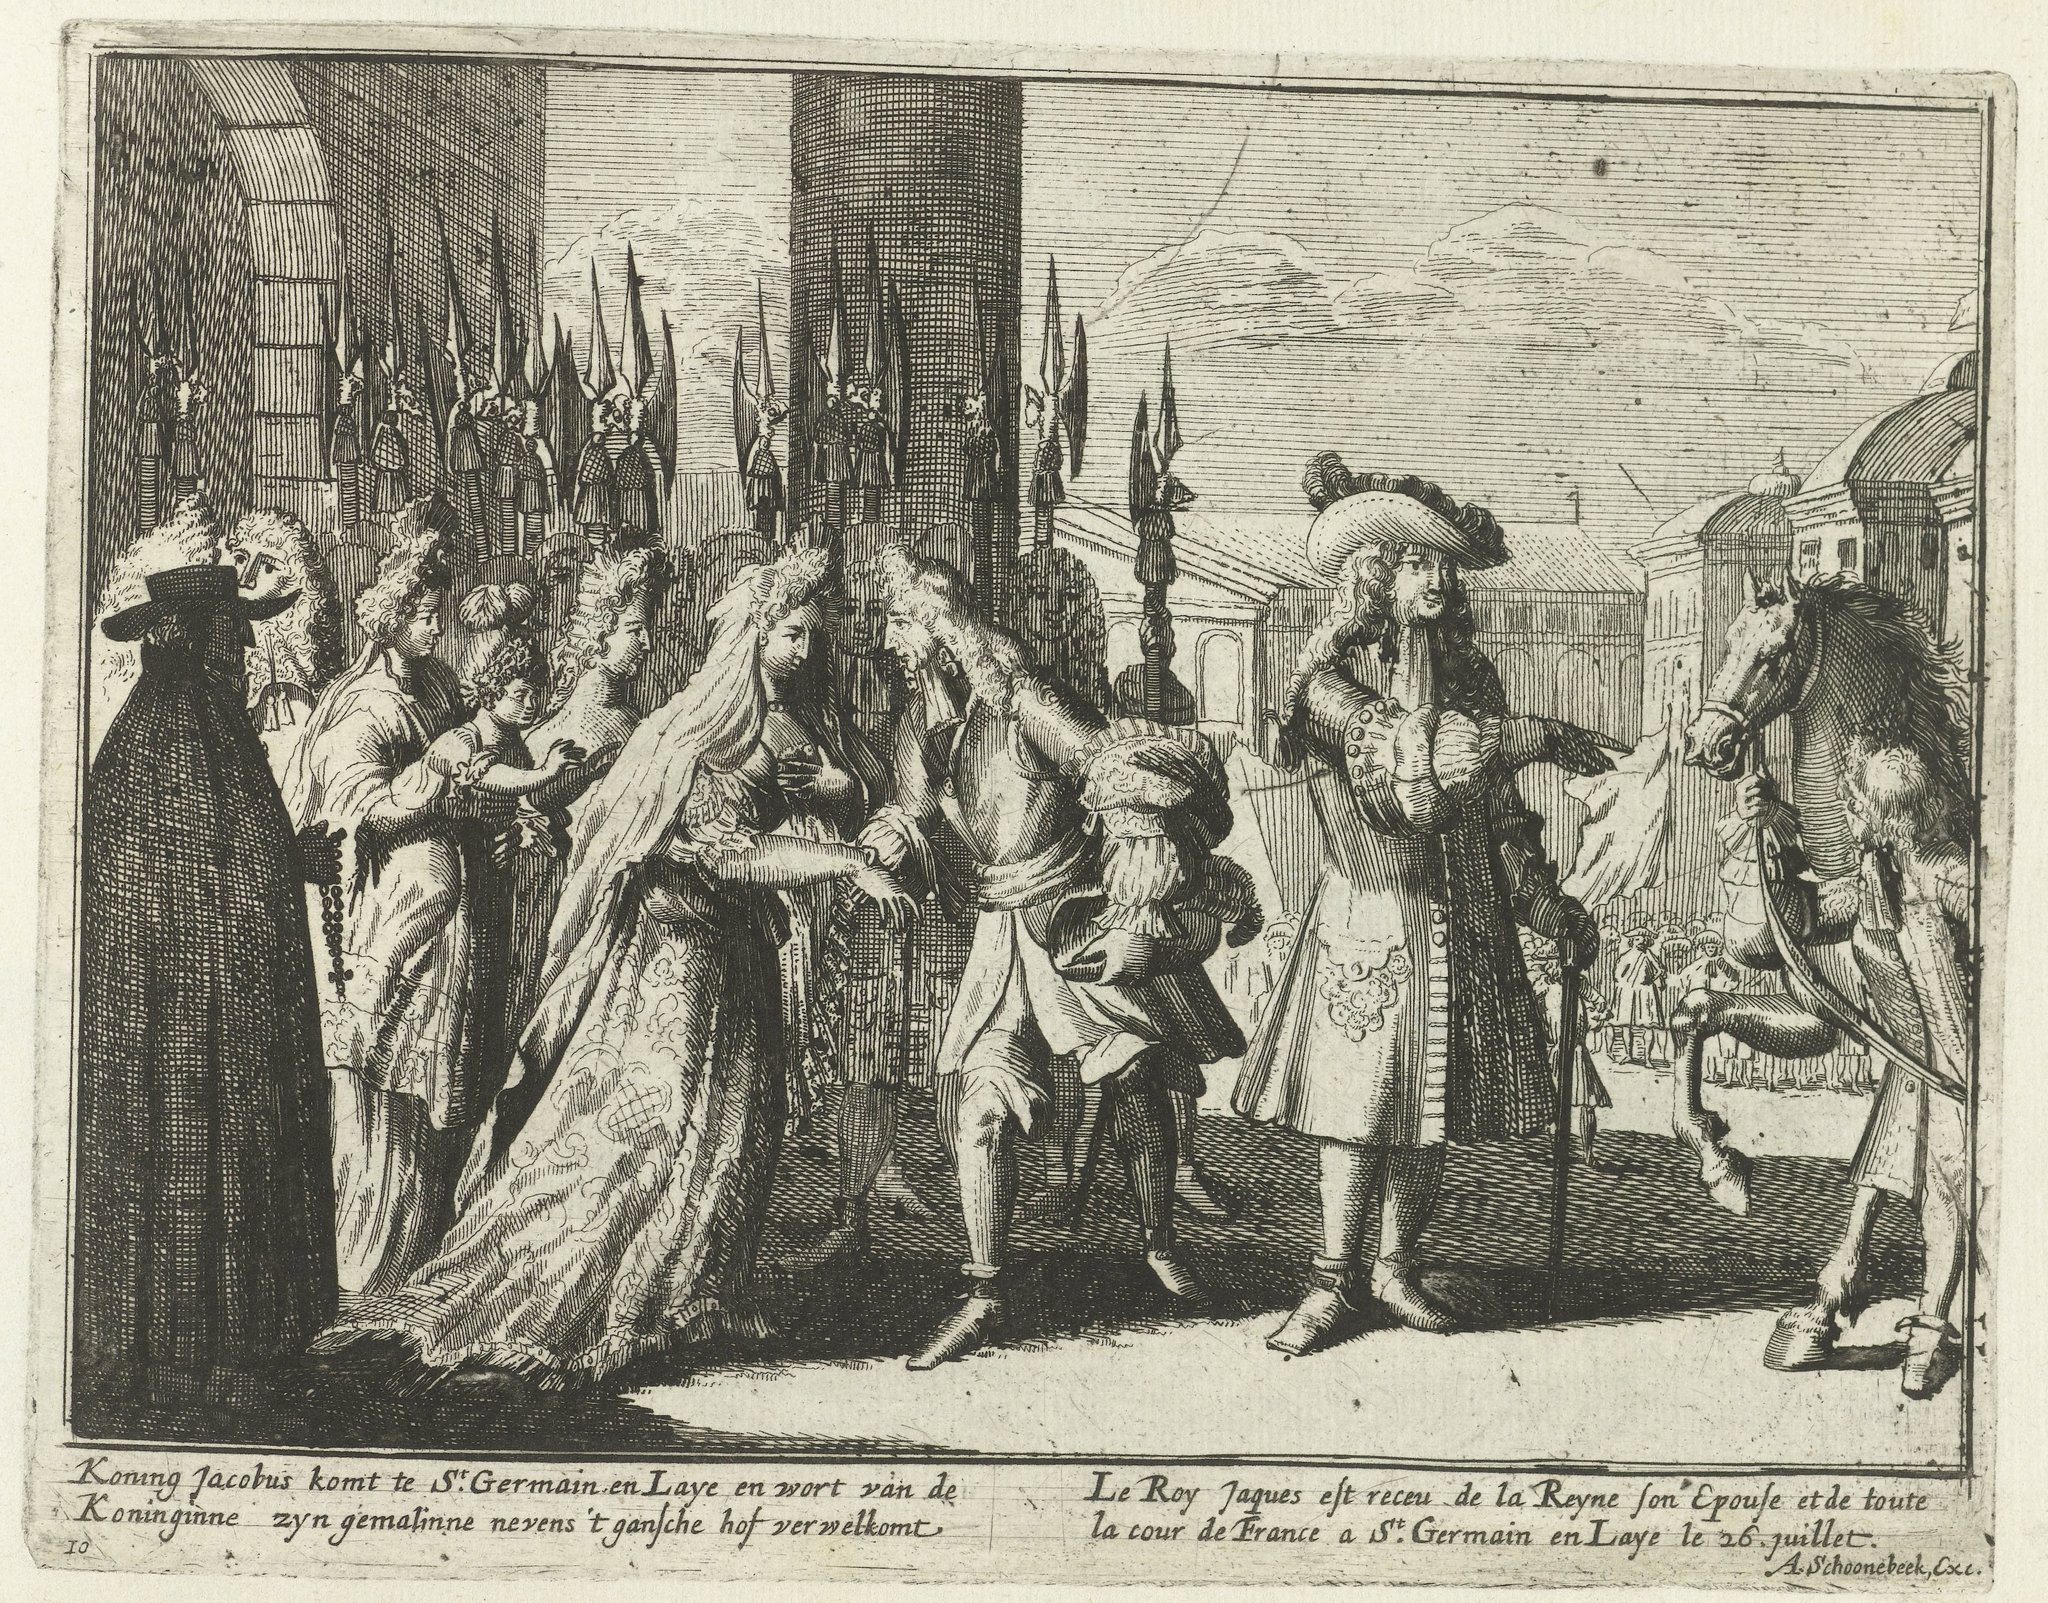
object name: print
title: Jacobus II komt aan te Saint-Germain-en-Laye, 1690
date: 1691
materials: paper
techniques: etching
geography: amsterdam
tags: jacobus ii (koning van engeland en schotland), paris, london, arrival and return ~ travelling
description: De gevluchte koning Jacobus II komt aan bij het kasteel Château de Saint-Germain-en-Laye waar hij wordt verwelkomd door koningin Maria van Modena met hun zoon de prins van Wales, juli 1690. Plaat nr. 10 in de serie 'Engelants schouwtoneel' over de oorlog tussen Willem III en Jacobus II in de jaren 1690-1691 na de Glorious Revolution, (derde deel). Met onderschriften in het Nederlands en Frans.